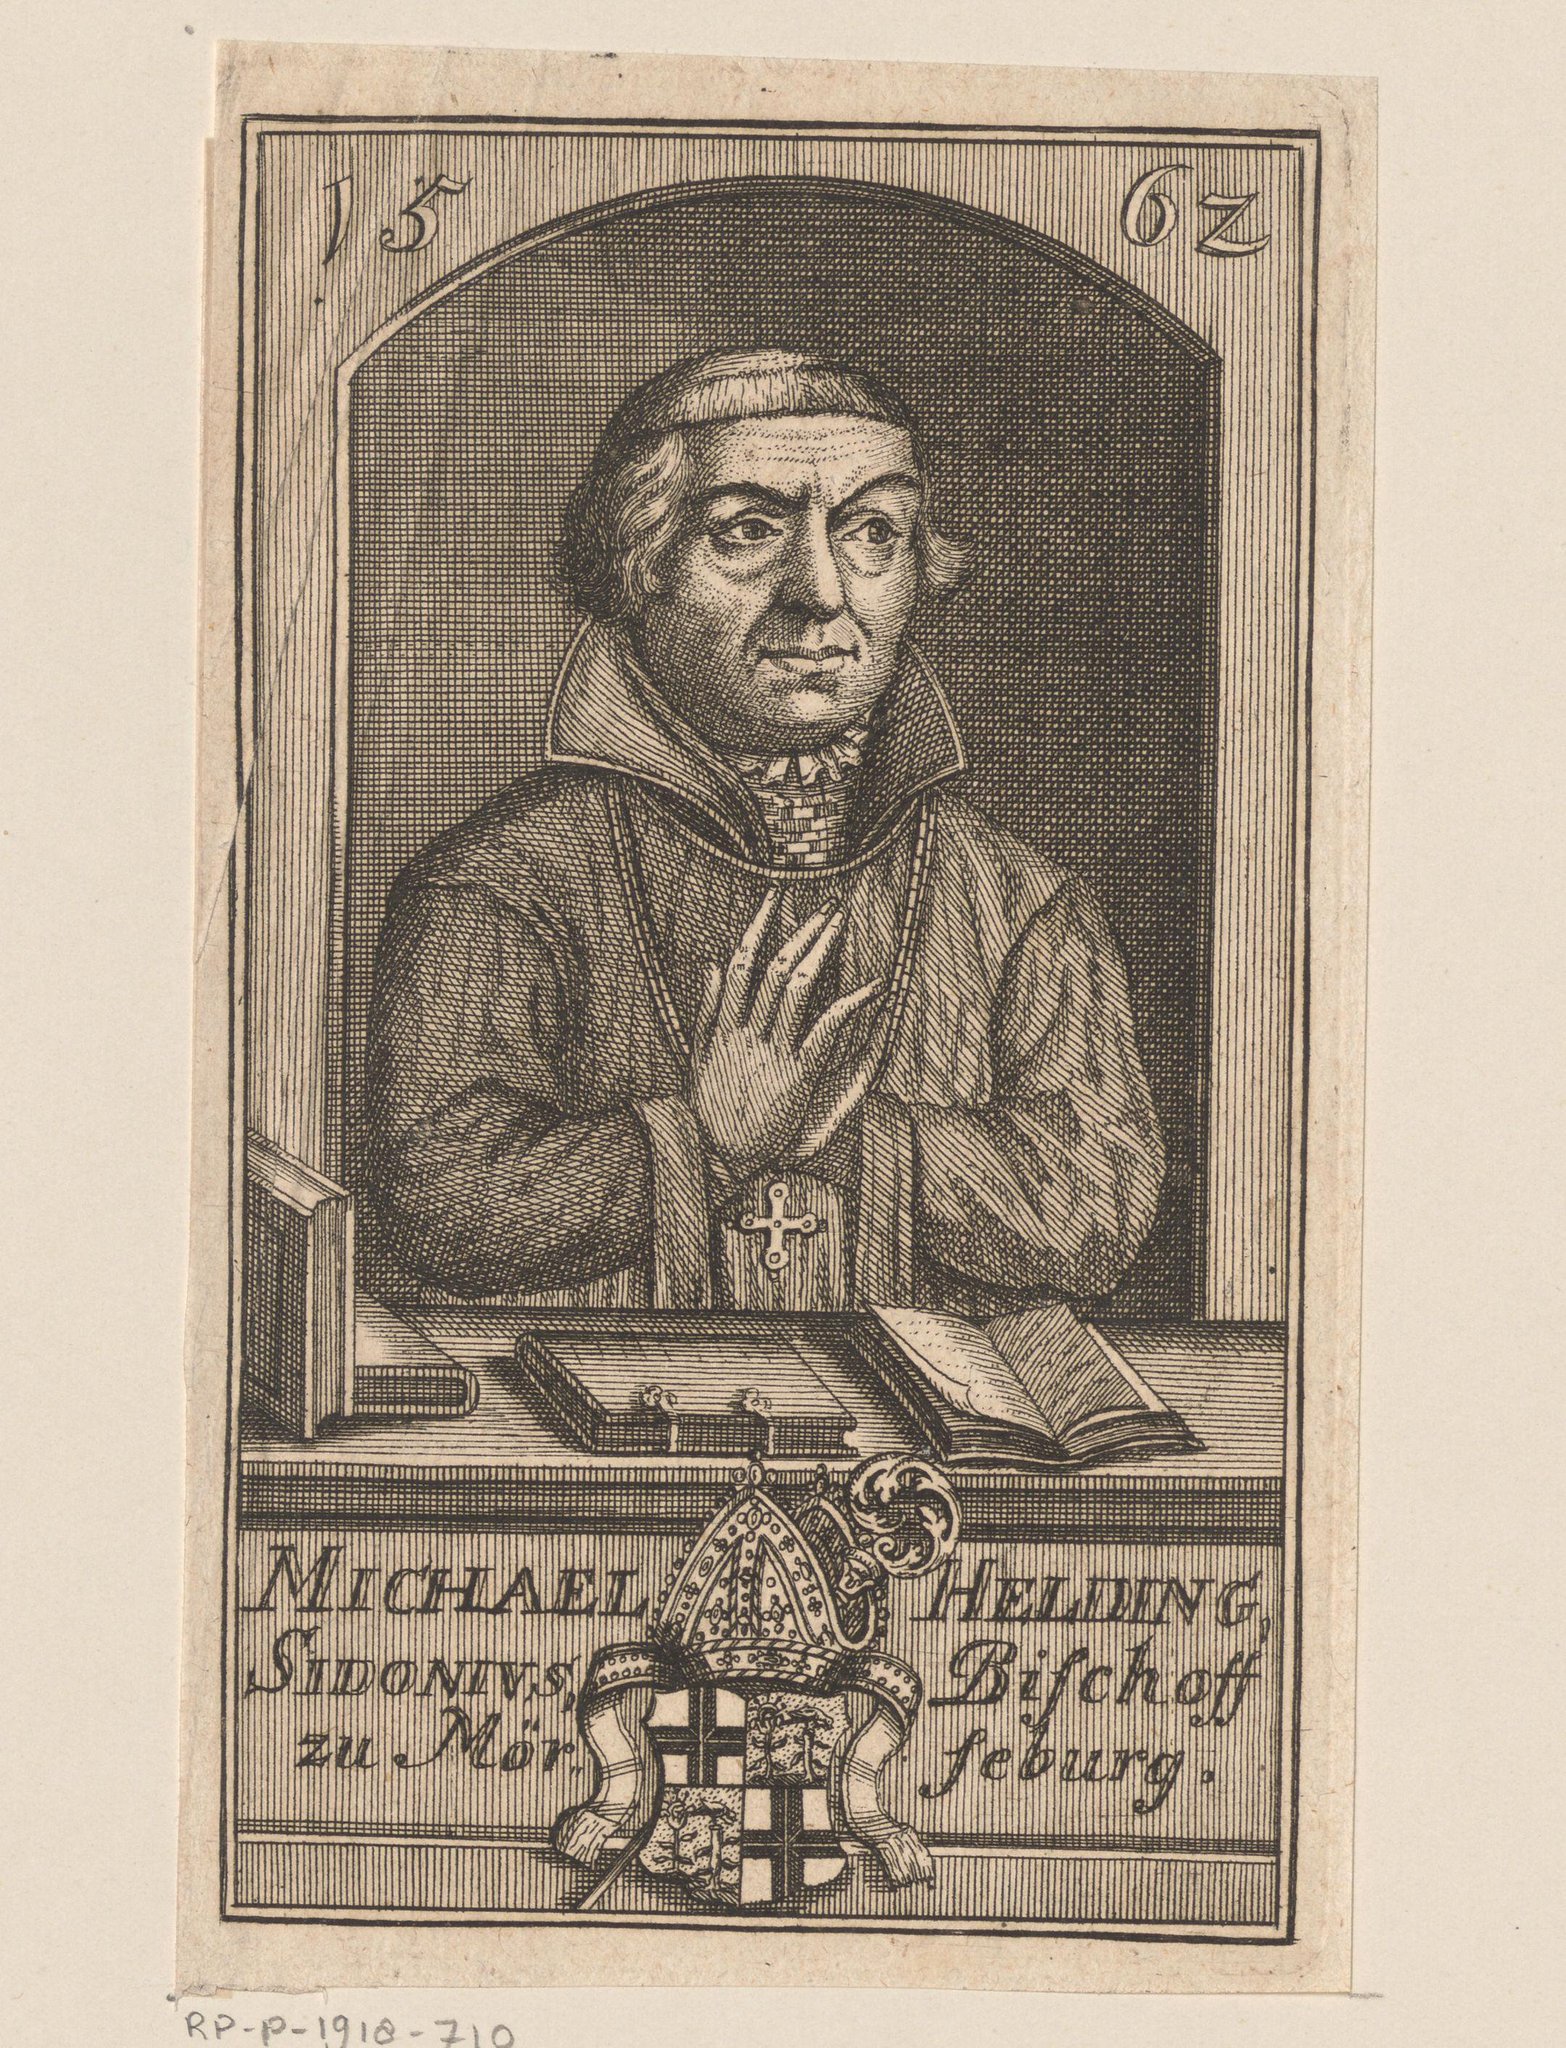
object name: book illustration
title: Portret van Michael Helding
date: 1716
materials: paper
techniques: engraving, etching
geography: leipzig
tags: archbishop, bishop, etc. (roman catholic), theologian, historical persons, book, armorial bearing, heraldry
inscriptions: collector's mark: Lugt 2233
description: Prent uit: Unschuldige Nachrichten von Alten und Neuen Theologischen Sachen. Leipzig: Johann Friedrich Braun, 1716.